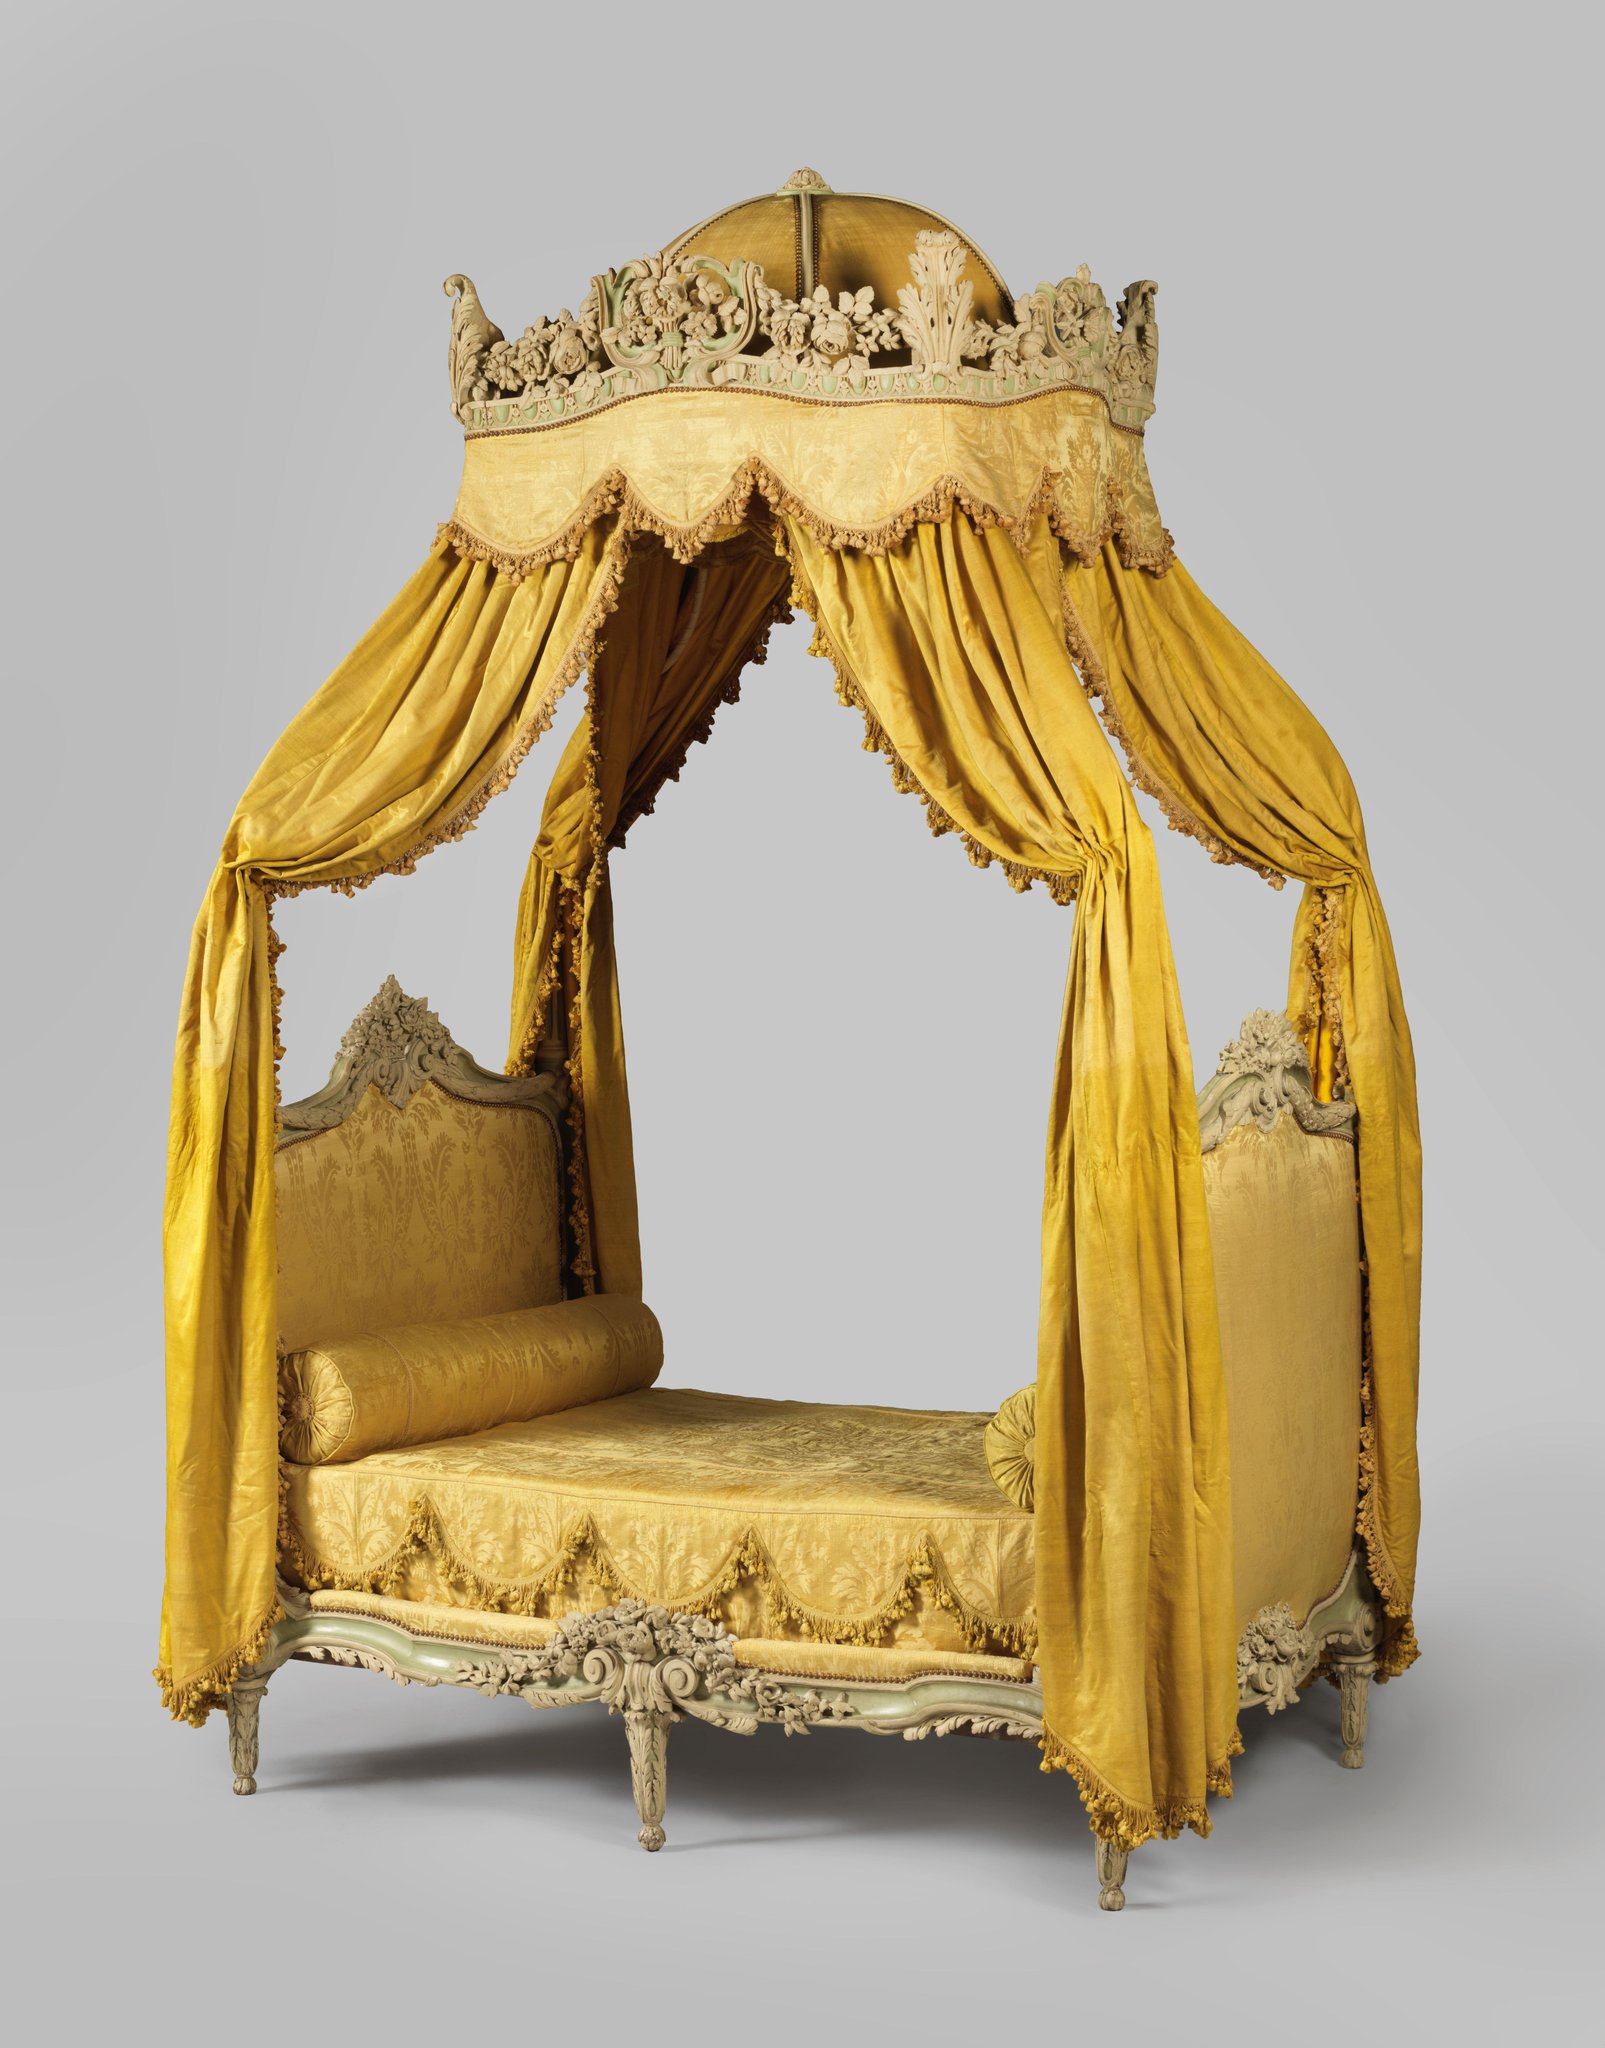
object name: bed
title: Zijschot van het Lit à la Polonaise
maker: Anonymous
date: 1775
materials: wood, copper, iron, paint, textile, silk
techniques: cutting, damask, painted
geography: france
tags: bed